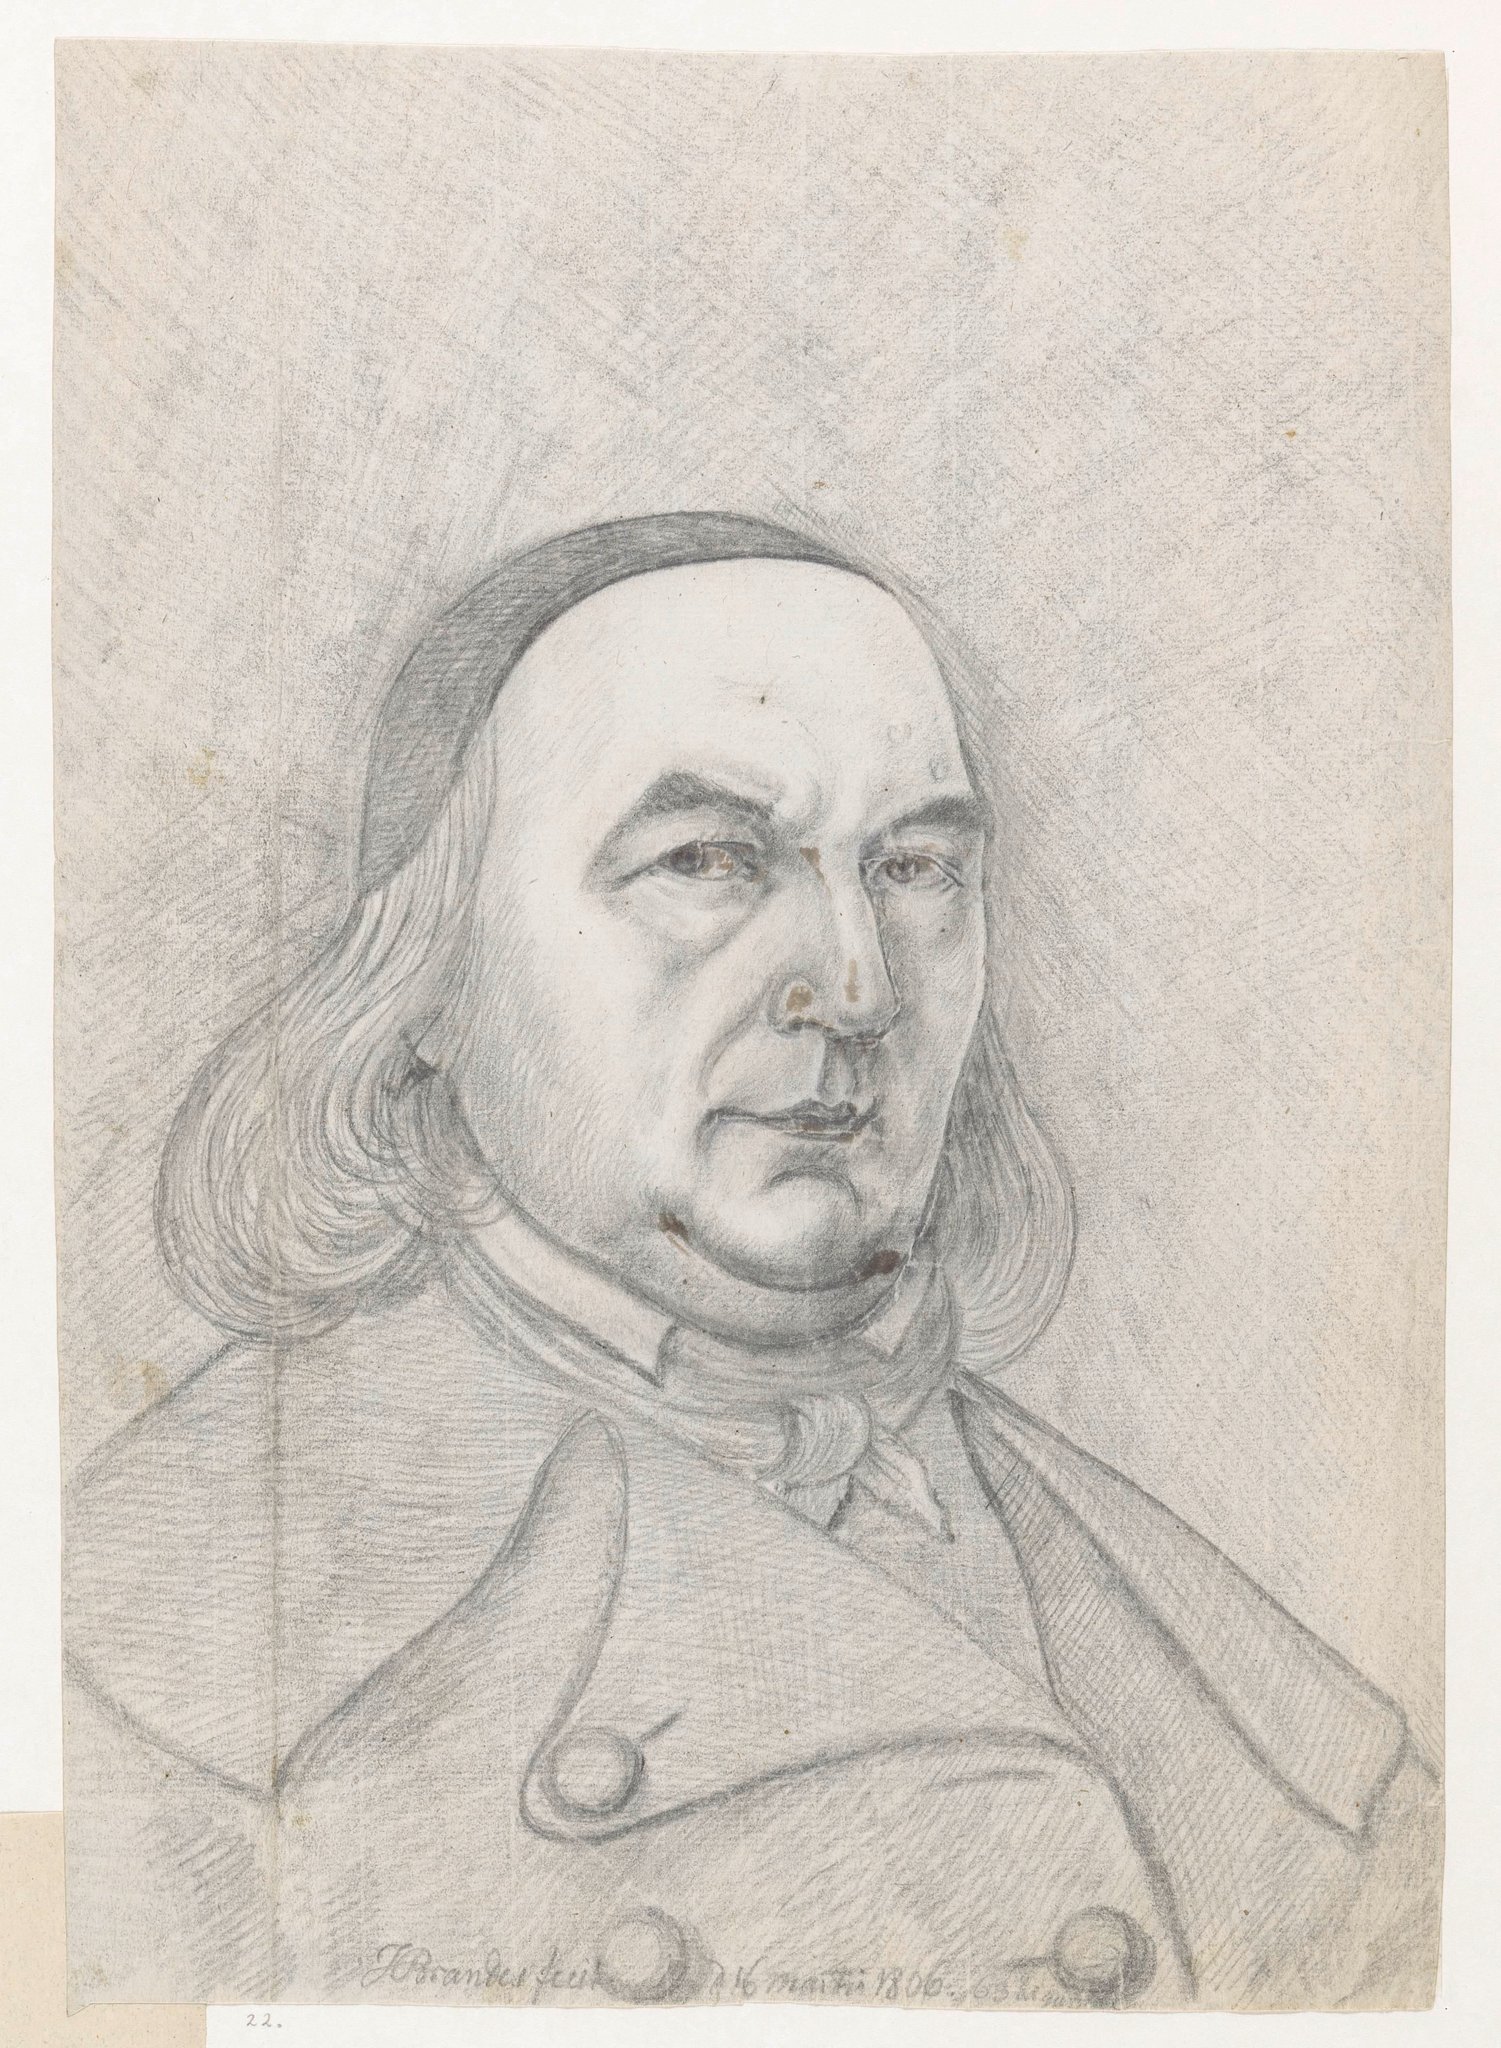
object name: drawing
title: Zelfportret van Jan Brandes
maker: jan brandes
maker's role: draughtsman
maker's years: 1743-1808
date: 1806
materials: paper, pencil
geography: skälsebo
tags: bodegraven, draughtsman, jan brandes, historical persons, portrait, self-portrait of artist, portrait, self-portrait of draughtsman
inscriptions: date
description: Zelfportret van de tekenaar met muts en zware jas. Driekwart naar rechts. Met opschrift.